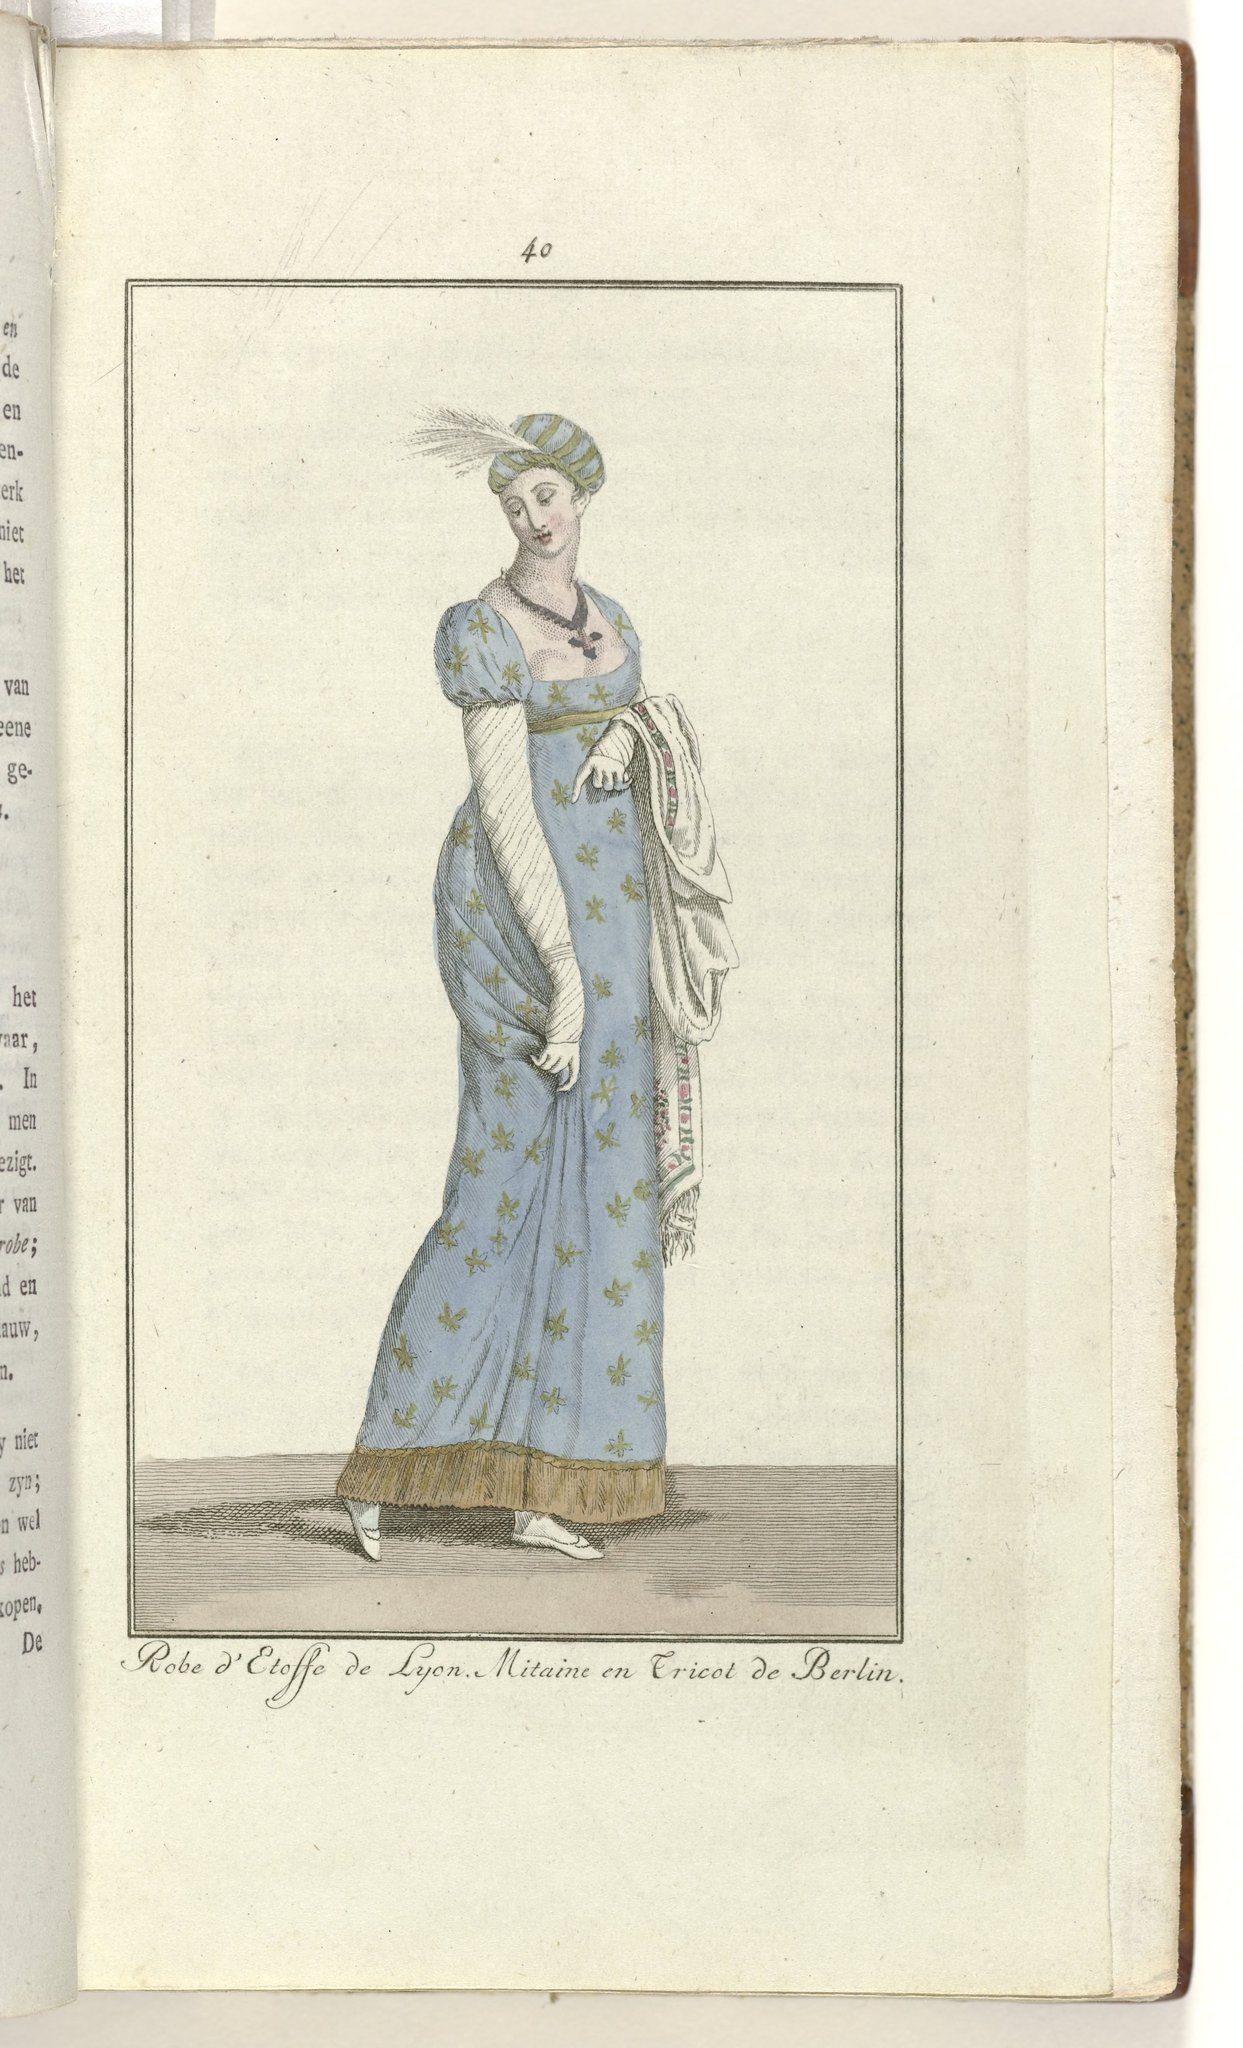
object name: fashion print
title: Elegantia, of tijdschrift van mode, luxe en smaak voor dames, Maart 1808, No. 40 : Robe d'Etoffe...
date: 1808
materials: paper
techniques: engraving, hand coloring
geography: amsterdam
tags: pendant, trinket, 'breloque' (+ women's clothes), clothing for the upper part of the body (shawl) (+ women's clothes), embroidery (ornamentation) (+ women's clothes), gloves, mittens (mitaines) (+ women's clothes), styles of hairdress - aa - ~ women, fashion plates, dress, gown (+ women's clothes)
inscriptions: caption: ‘Robe d'Etoffe de Lyon. Mitaine en Tricot de Berlin.’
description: Volgens de begeleidende tekst (p. 96): hemelsblauwe japon van 'étoffe de Lyon' met gouden sterren geborduurd en gouden franjes. 'Coëffure' van dezelfde stof met gouden strepen en een 'spirale'. Volgens het onderschrift: mitaines van 'tricot de Berlin'. Prent uit het modetijdschrift Elegantia, of tijdschrift van mode, luxe en smaak voor dames 1807-1814 (onderbroken door de periode 1811-1813).